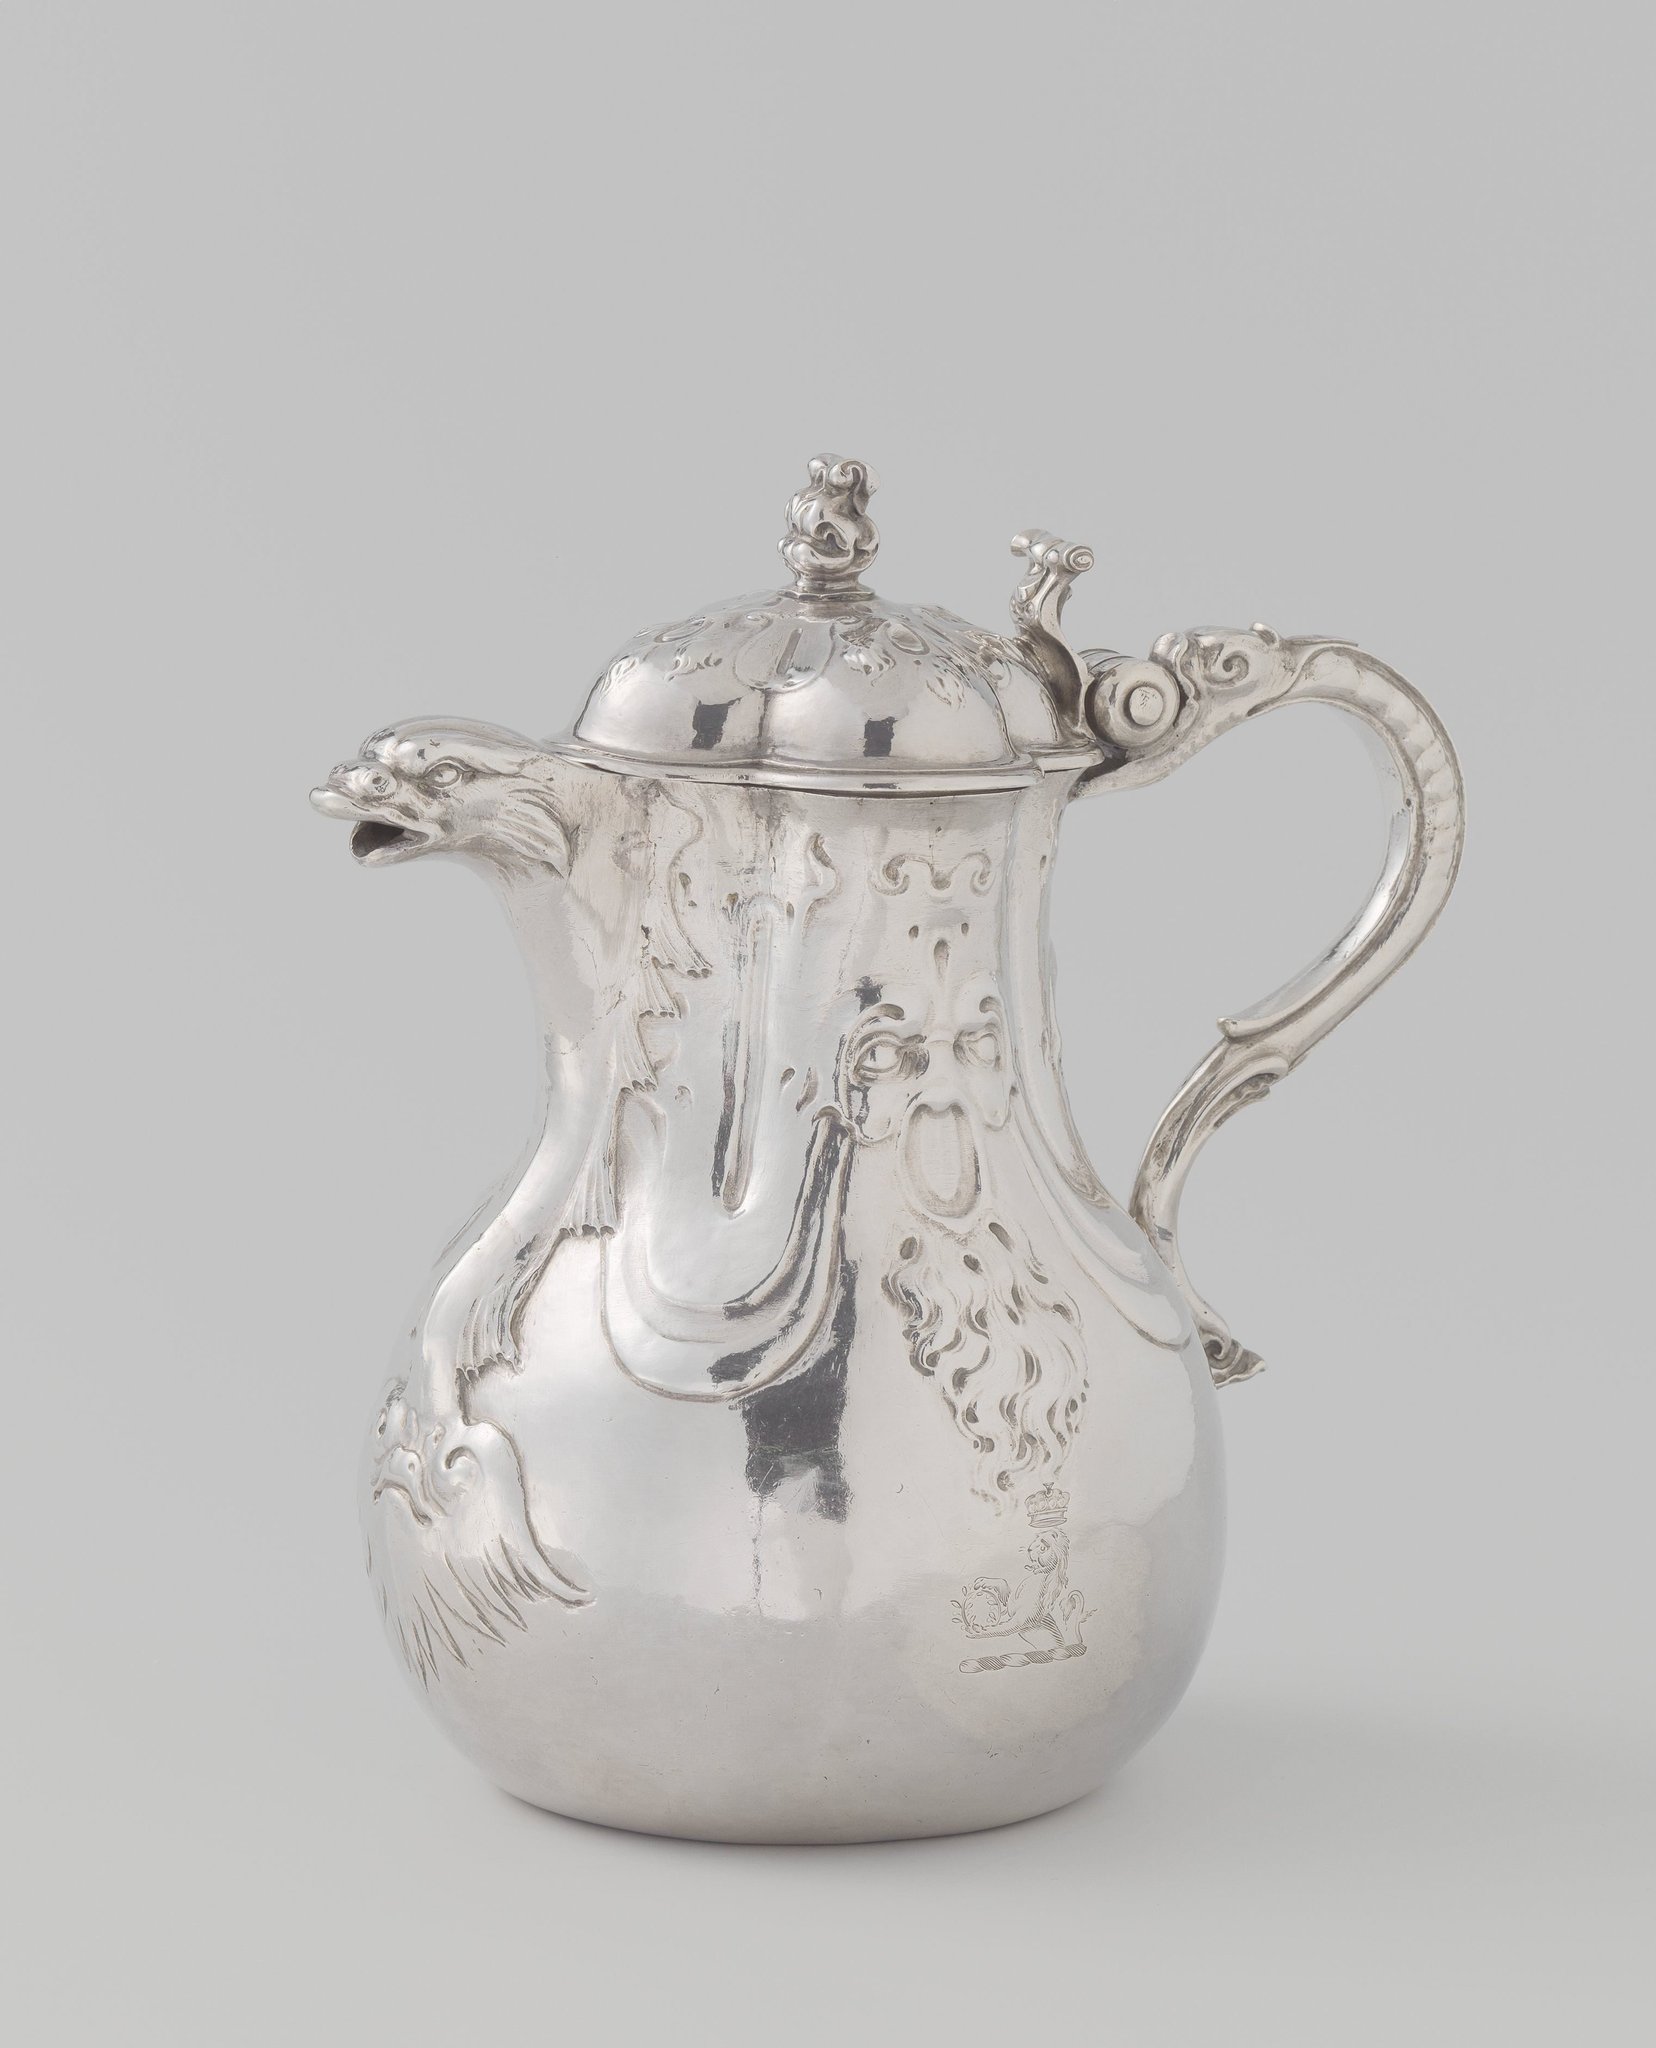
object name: ewer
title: Two Jugs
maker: john cooqus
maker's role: silversmith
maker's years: 1650-1697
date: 1660-1665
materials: silver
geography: london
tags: auricular ornament, lobe style ~ ornament, dragon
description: Christiaen lived in Utrecht during the British Civil War (1642-1660), but afterwards he returned to London where he worked together with John Cooqus, who married his daughter. Christiaen probably collaborated on the jug at the left. The one at the right, which is less well finished, is probably solely Cooqus’s work. Kwab ornament is still very prominent in these late pieces.